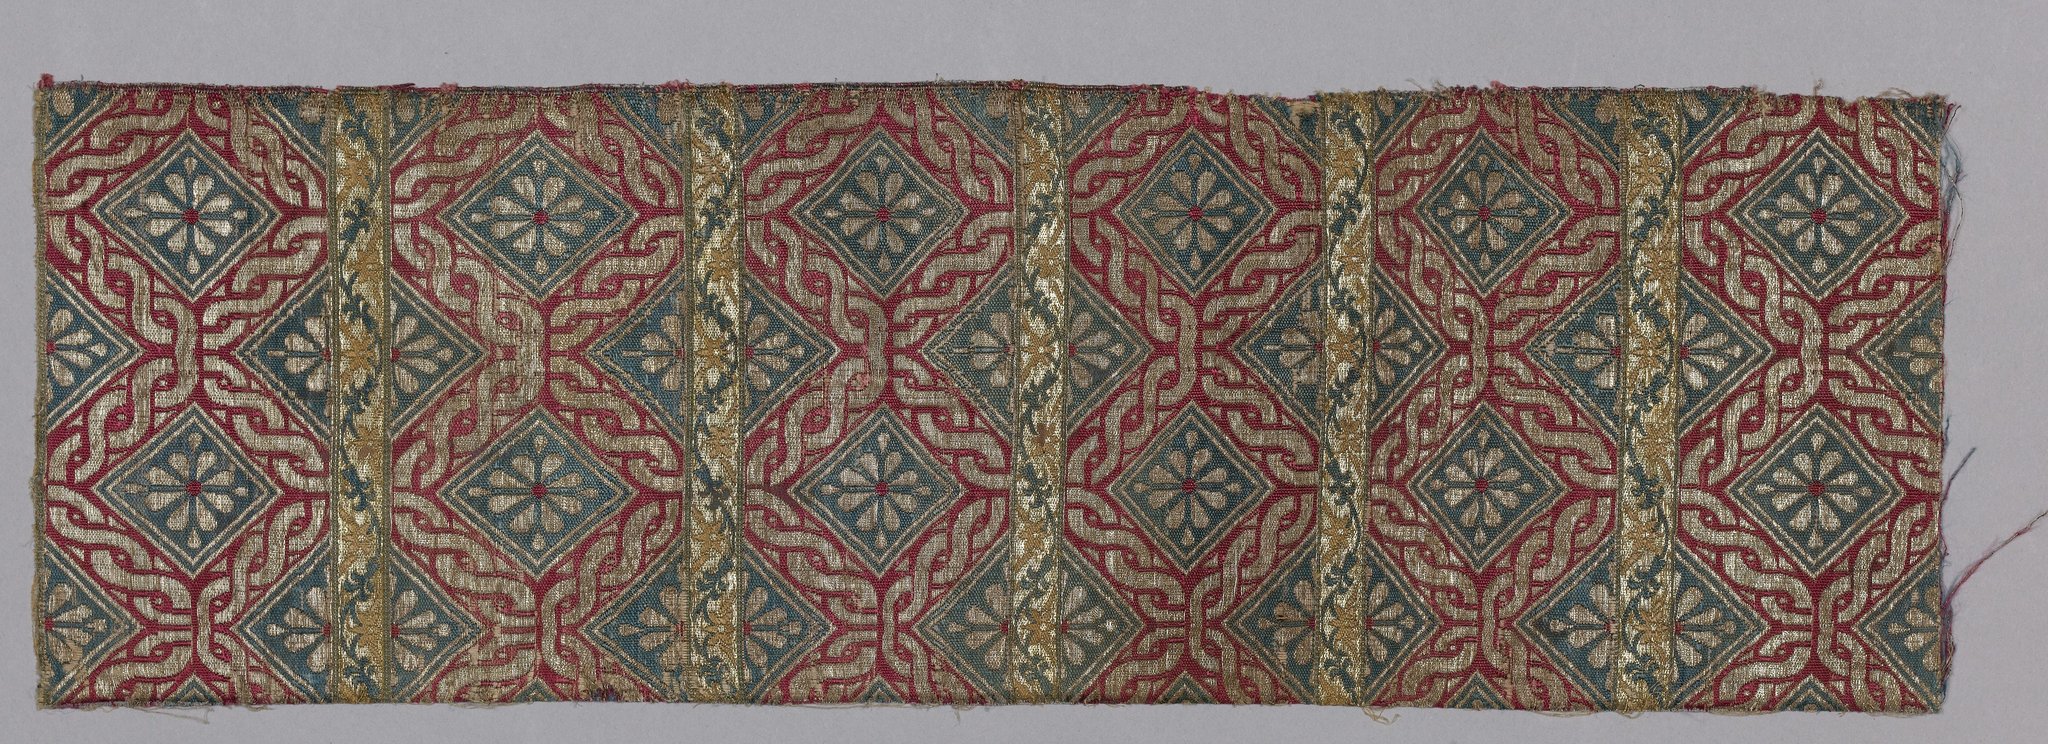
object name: textile fragment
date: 1501-1550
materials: metal thread, silk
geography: turkey